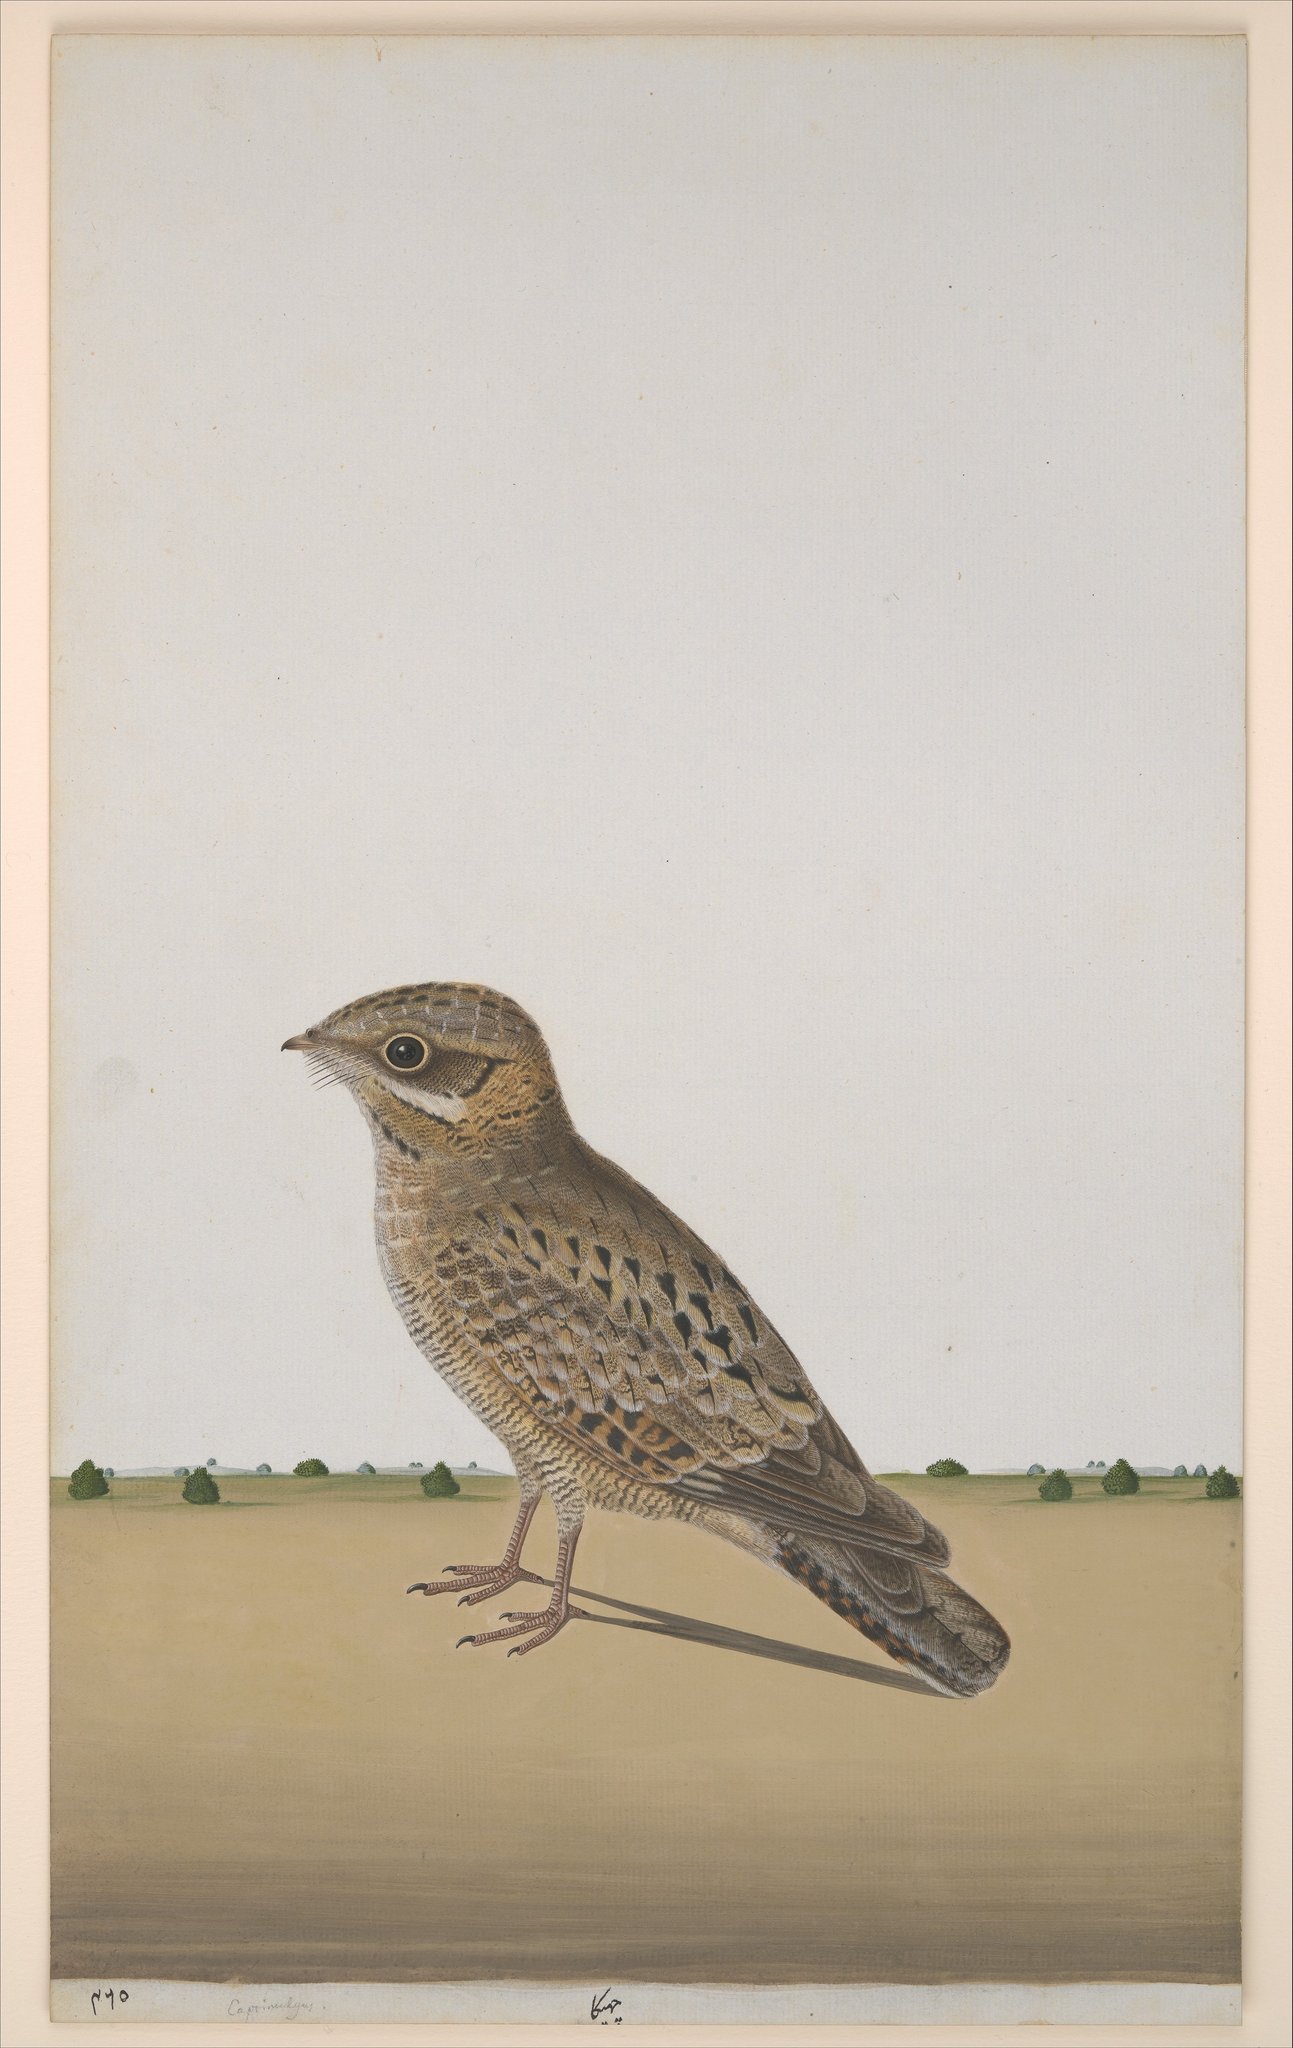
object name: illustrated single work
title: A Common Indian Nightjar (Caprimulgus asiaticus)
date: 1780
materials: paper, watercolor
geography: india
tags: birds